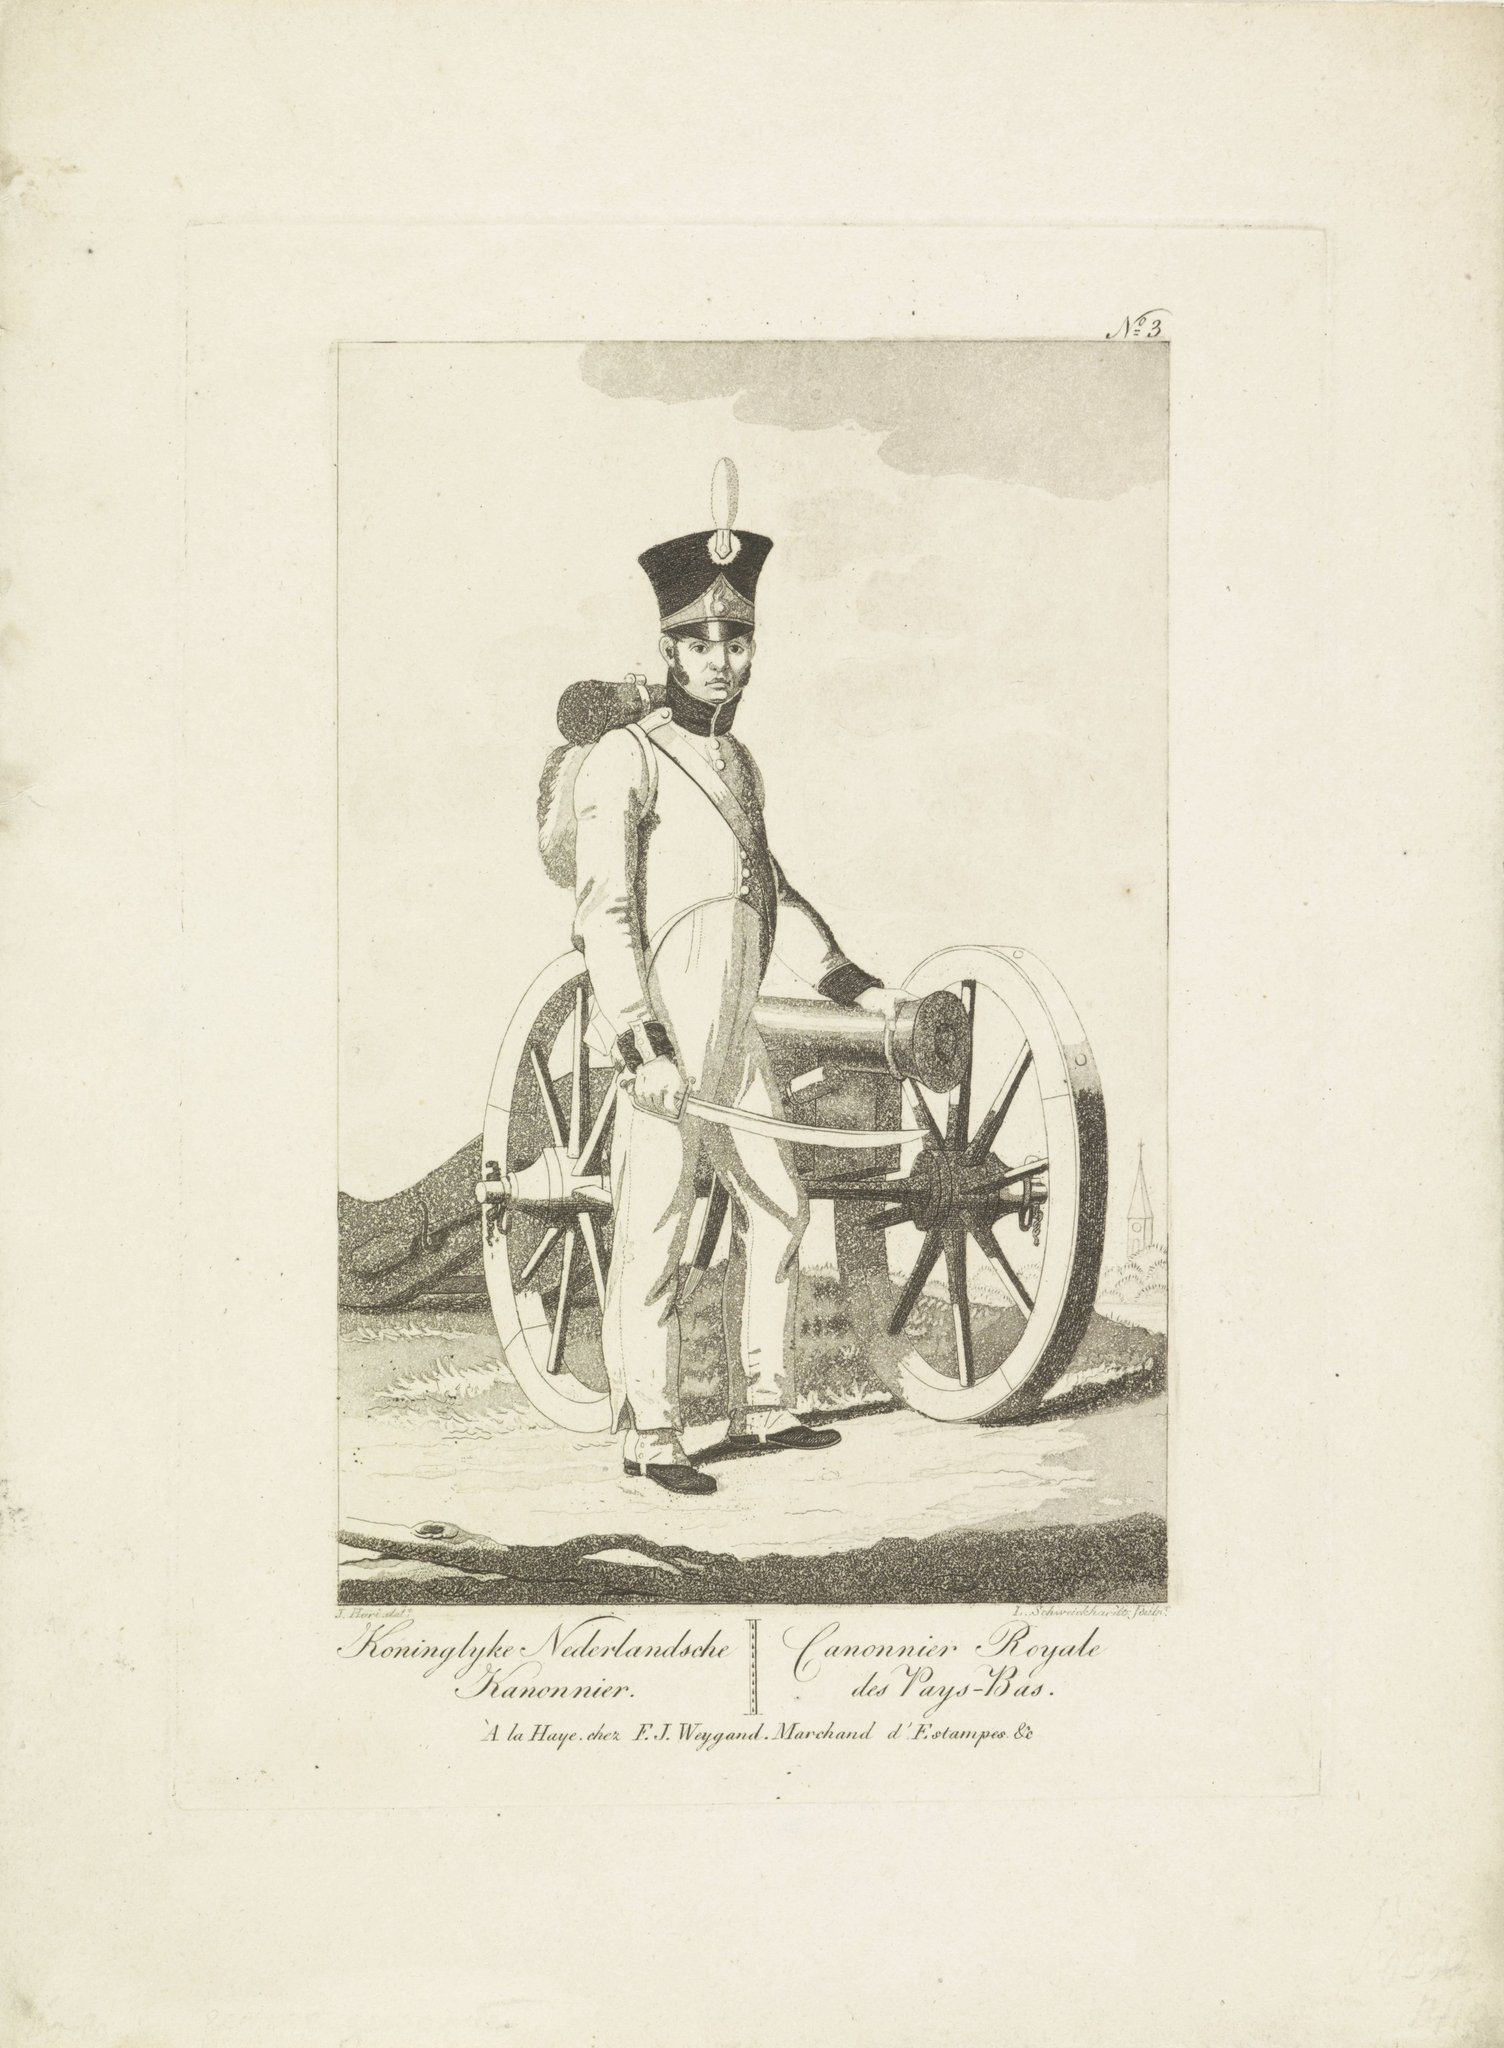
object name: costume print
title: Zeven uniformvoorstellingen 1814-1818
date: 1814-1818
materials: paper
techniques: aquatint, etching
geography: the hague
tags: (military) uniforms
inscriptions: collector's mark: Lugt 2228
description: Uniformvoorstelling van een kanonnier staande naast een stuk geschut. Genummerd rechtsboven: Pl. 3. Onderdeel van een reeks van zeven platen van uniformen van de militairen van het Koninkrijk der Nederlanden in de periode 1814-1818.